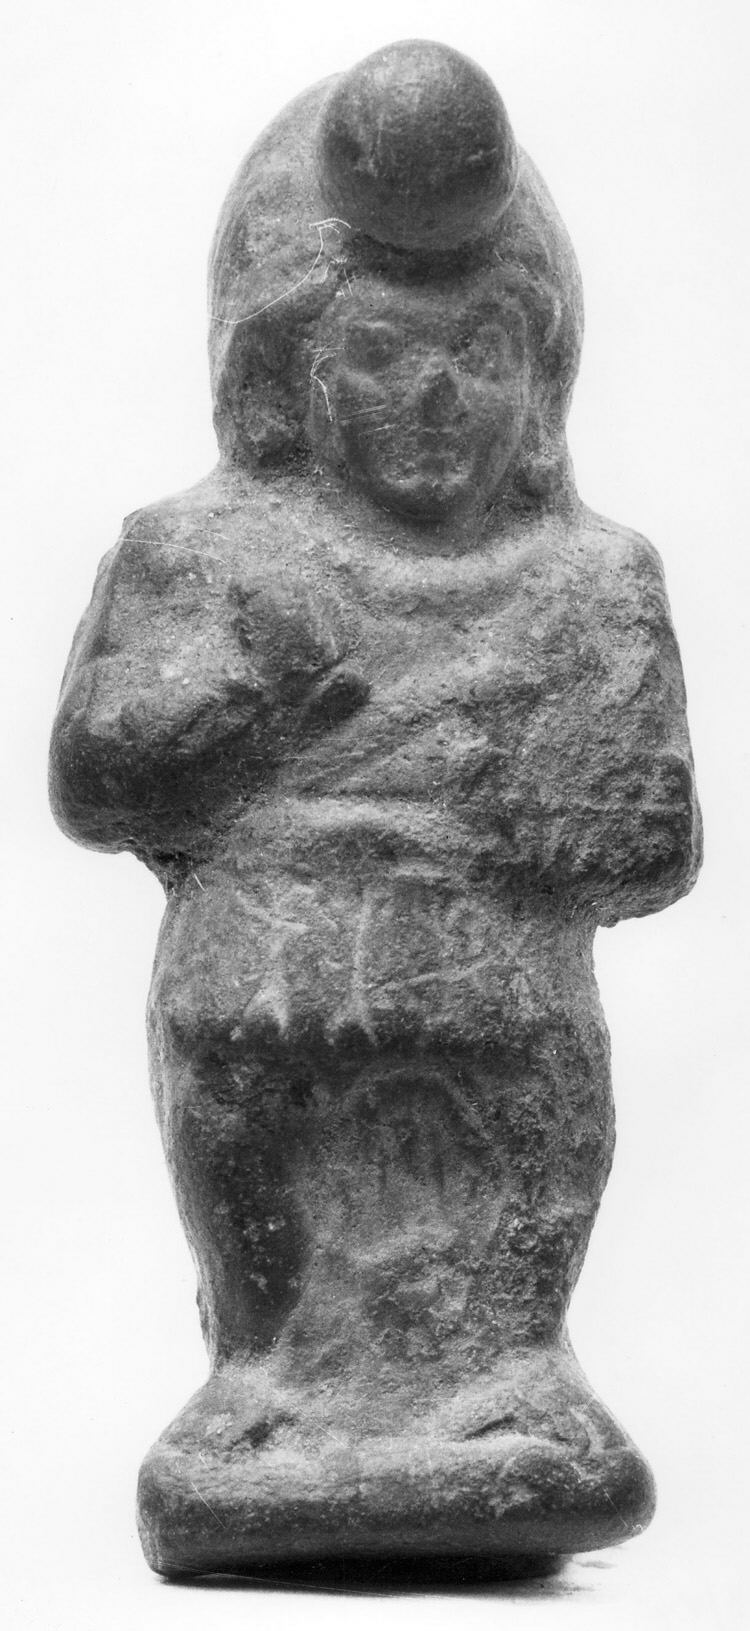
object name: statuette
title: Soldier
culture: indian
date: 200-1 BCE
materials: terracotta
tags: human figures,shunga,soldiers